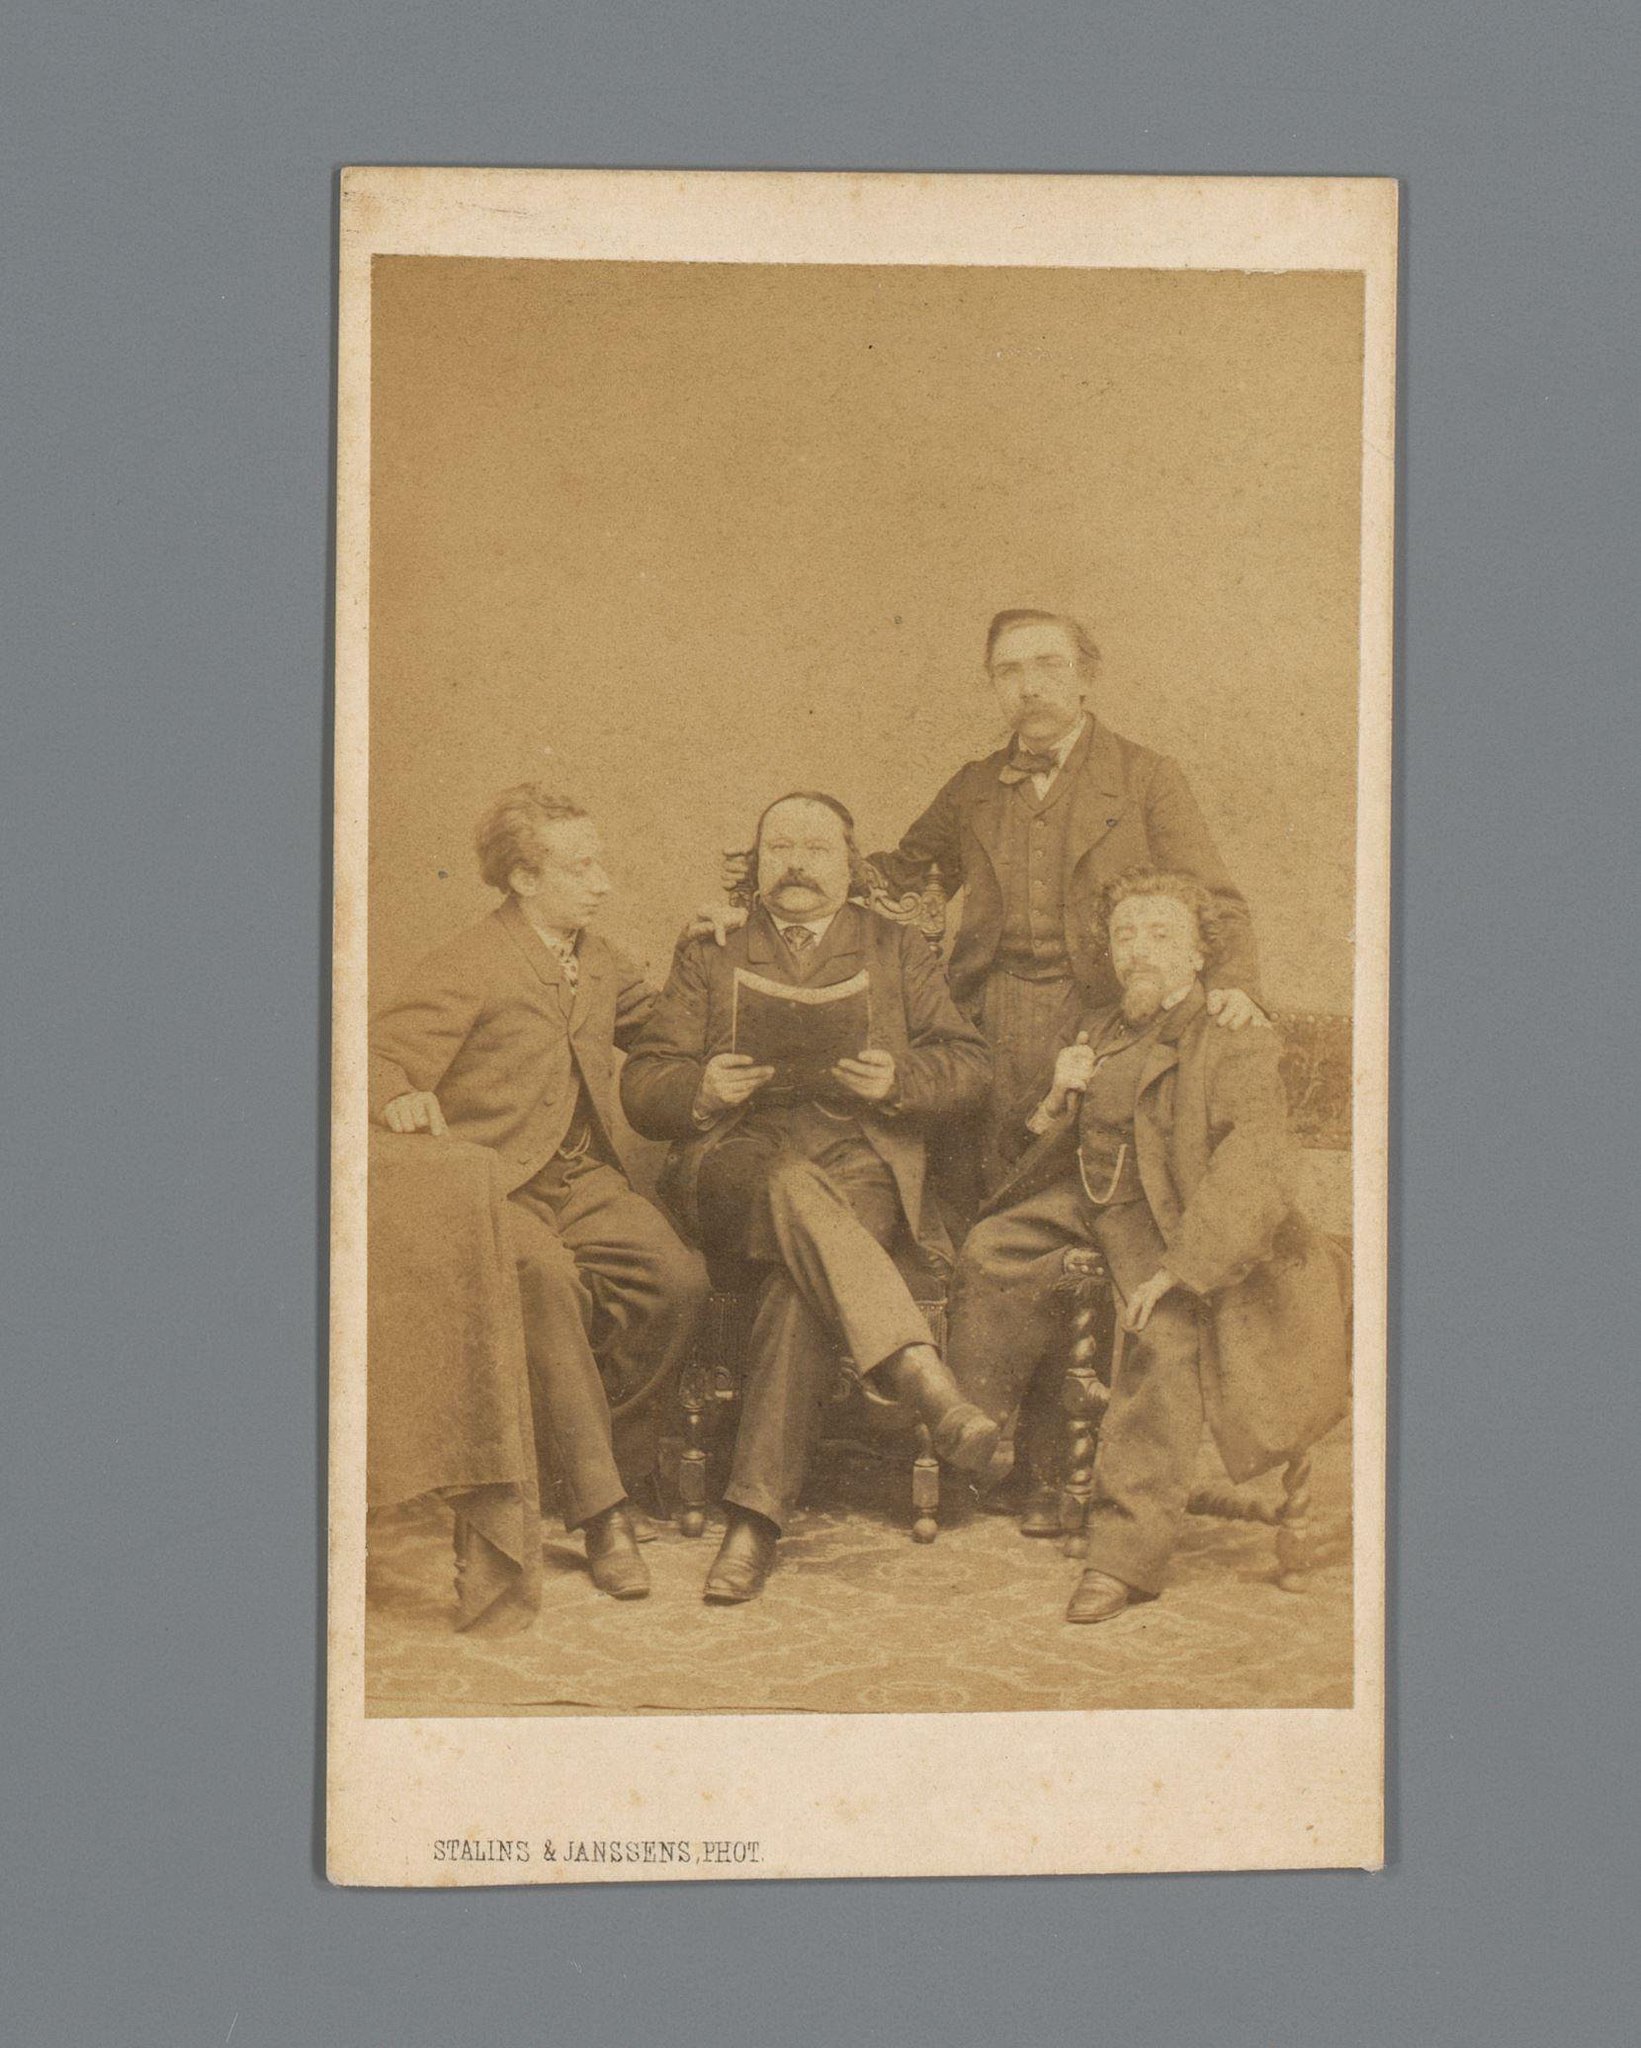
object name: photograph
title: Groepsportret met v.l.n.r. de glasschilder Alphonse Janssens, de componist en organist Robson, Van den Branden en de graveur Josephus Nauwens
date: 1866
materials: cardboard, paper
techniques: albumen print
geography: antwerp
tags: antwerp, print maker, josephus nauwens, historical persons, portrait of composer, portrait, self-portrait of painter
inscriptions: inscription: ‘Etablissement Photographique/ de/ Stalins & Janssens/ 38, Rempart du Lombard, 38/ Anvers.’, inscription: ‘Stalins & Janssens, Phot.’, inscription: ‘Jef Nauwens/ graveur/ Van den Branden/ Robson/ compositeur &/ organiste/ Alph. Janssens/ peintre sur verre/ 1866.’